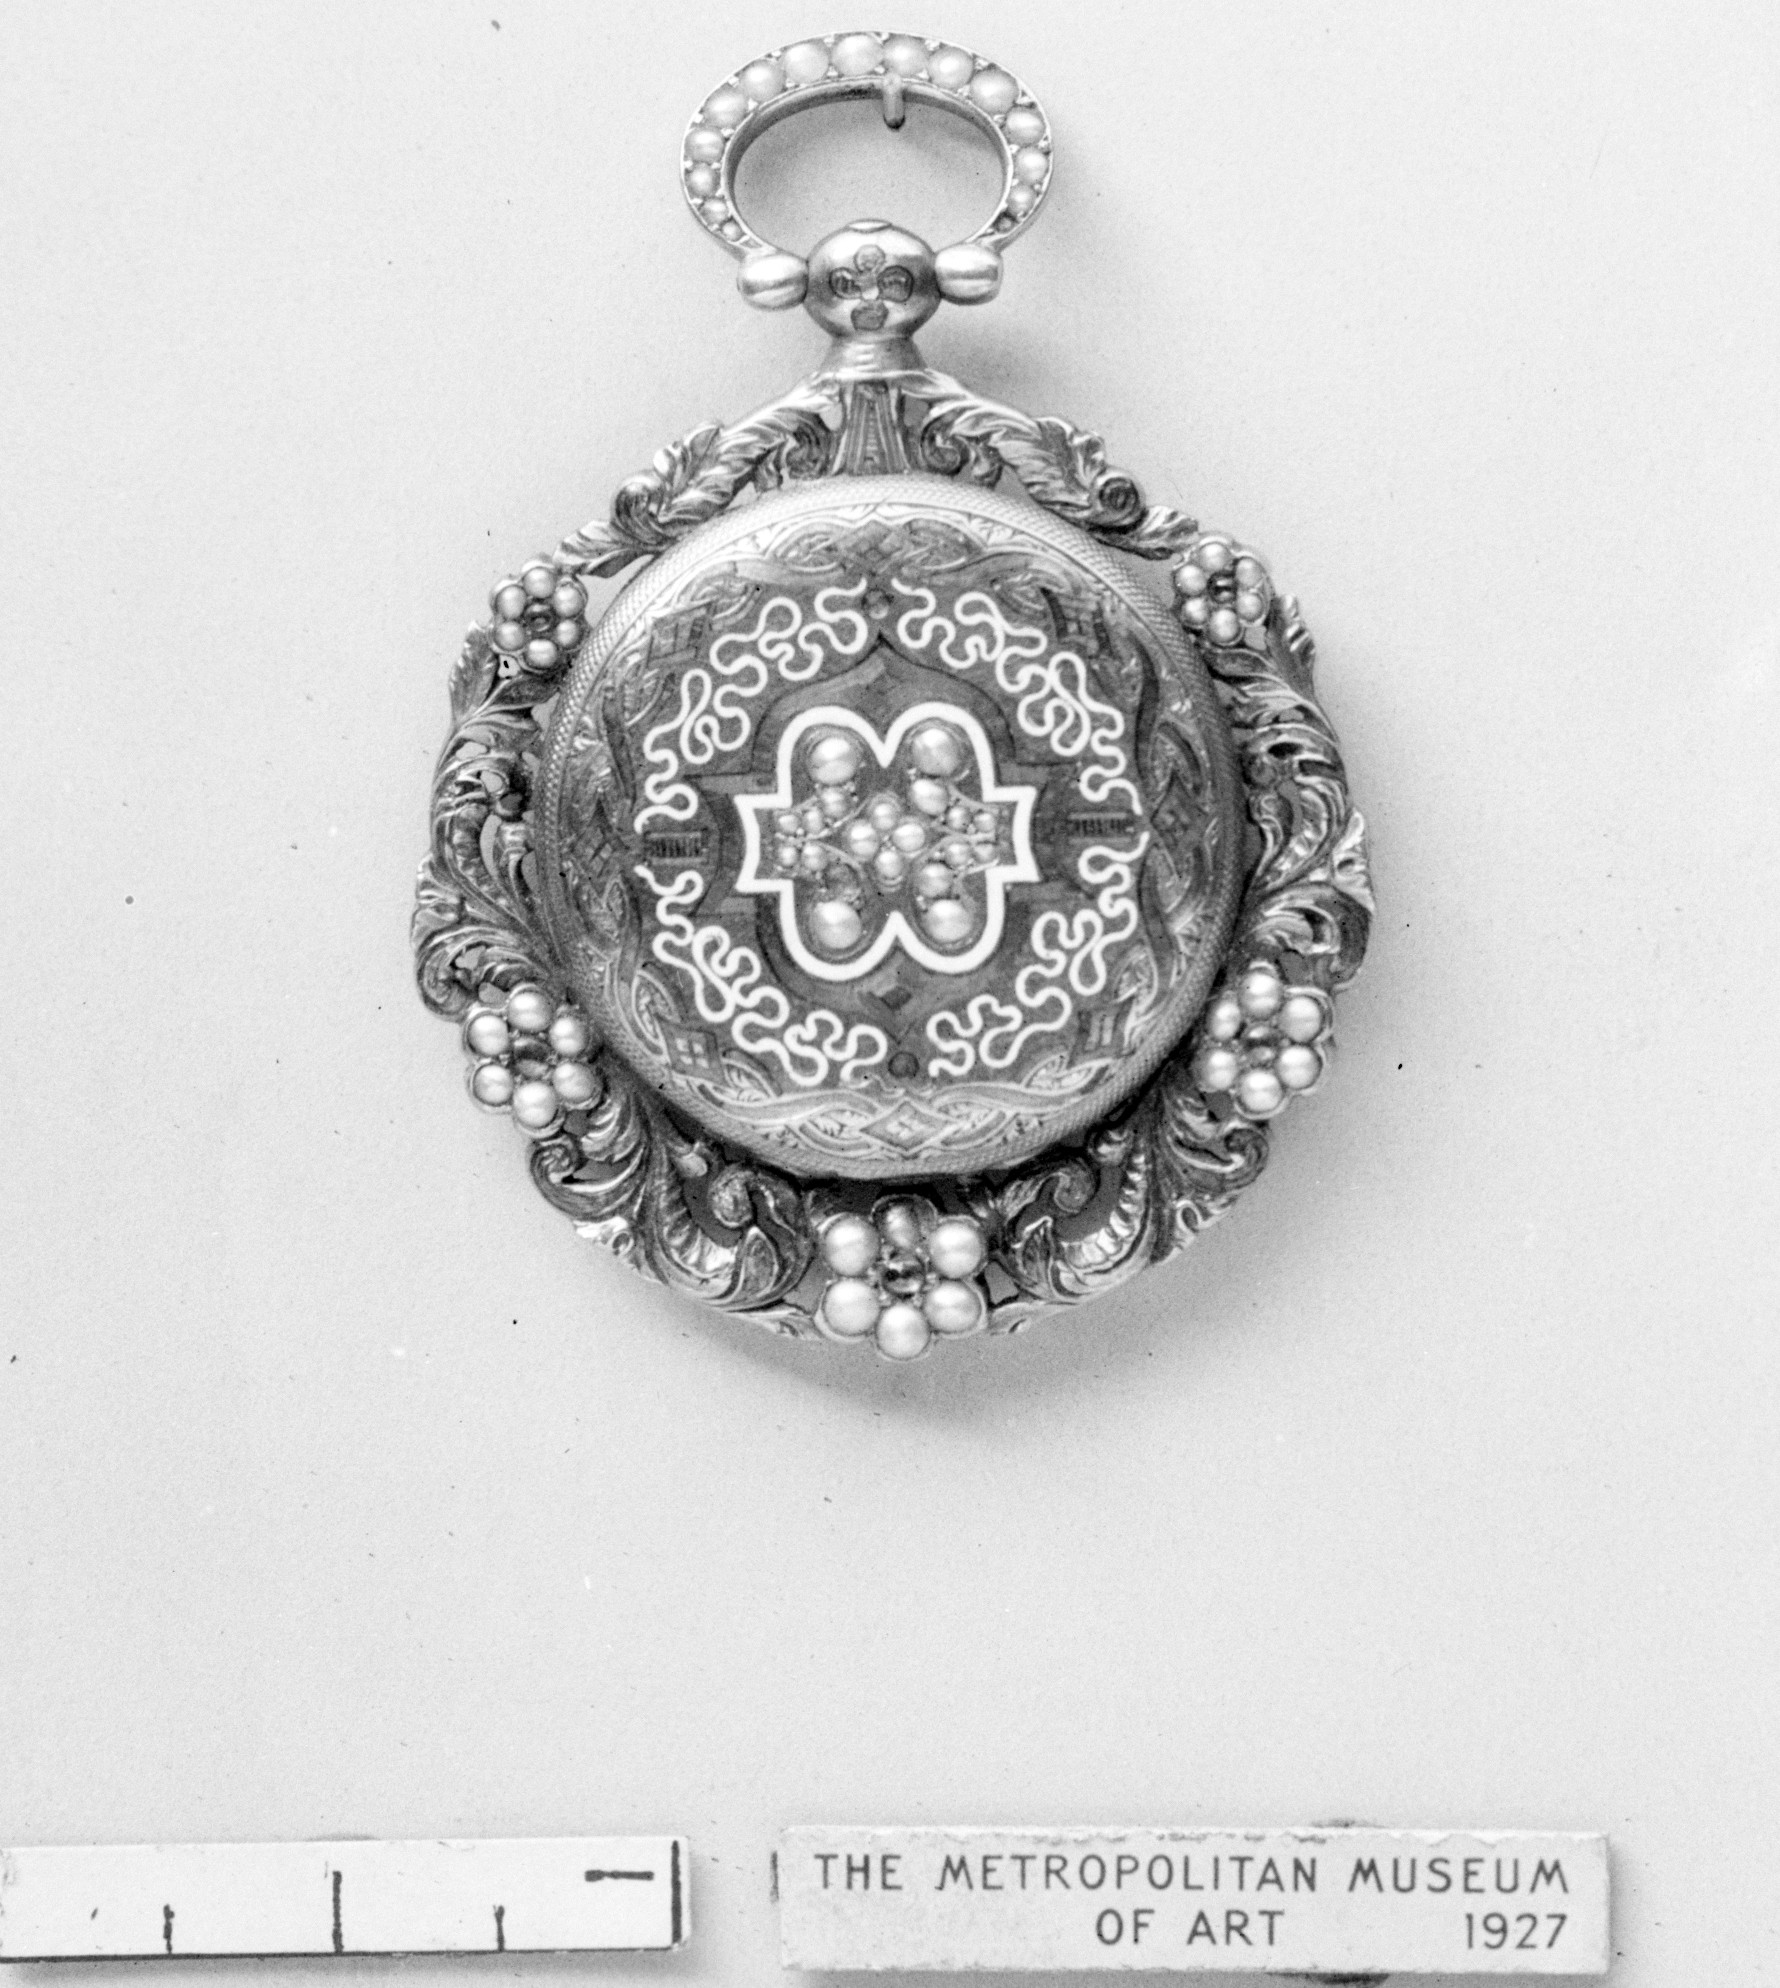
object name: watch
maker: jean-françois bautte & co.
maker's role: maker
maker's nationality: swiss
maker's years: 1837-1855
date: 1837-1855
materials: enamel, garnet, gold, pearl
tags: flowers,leaves